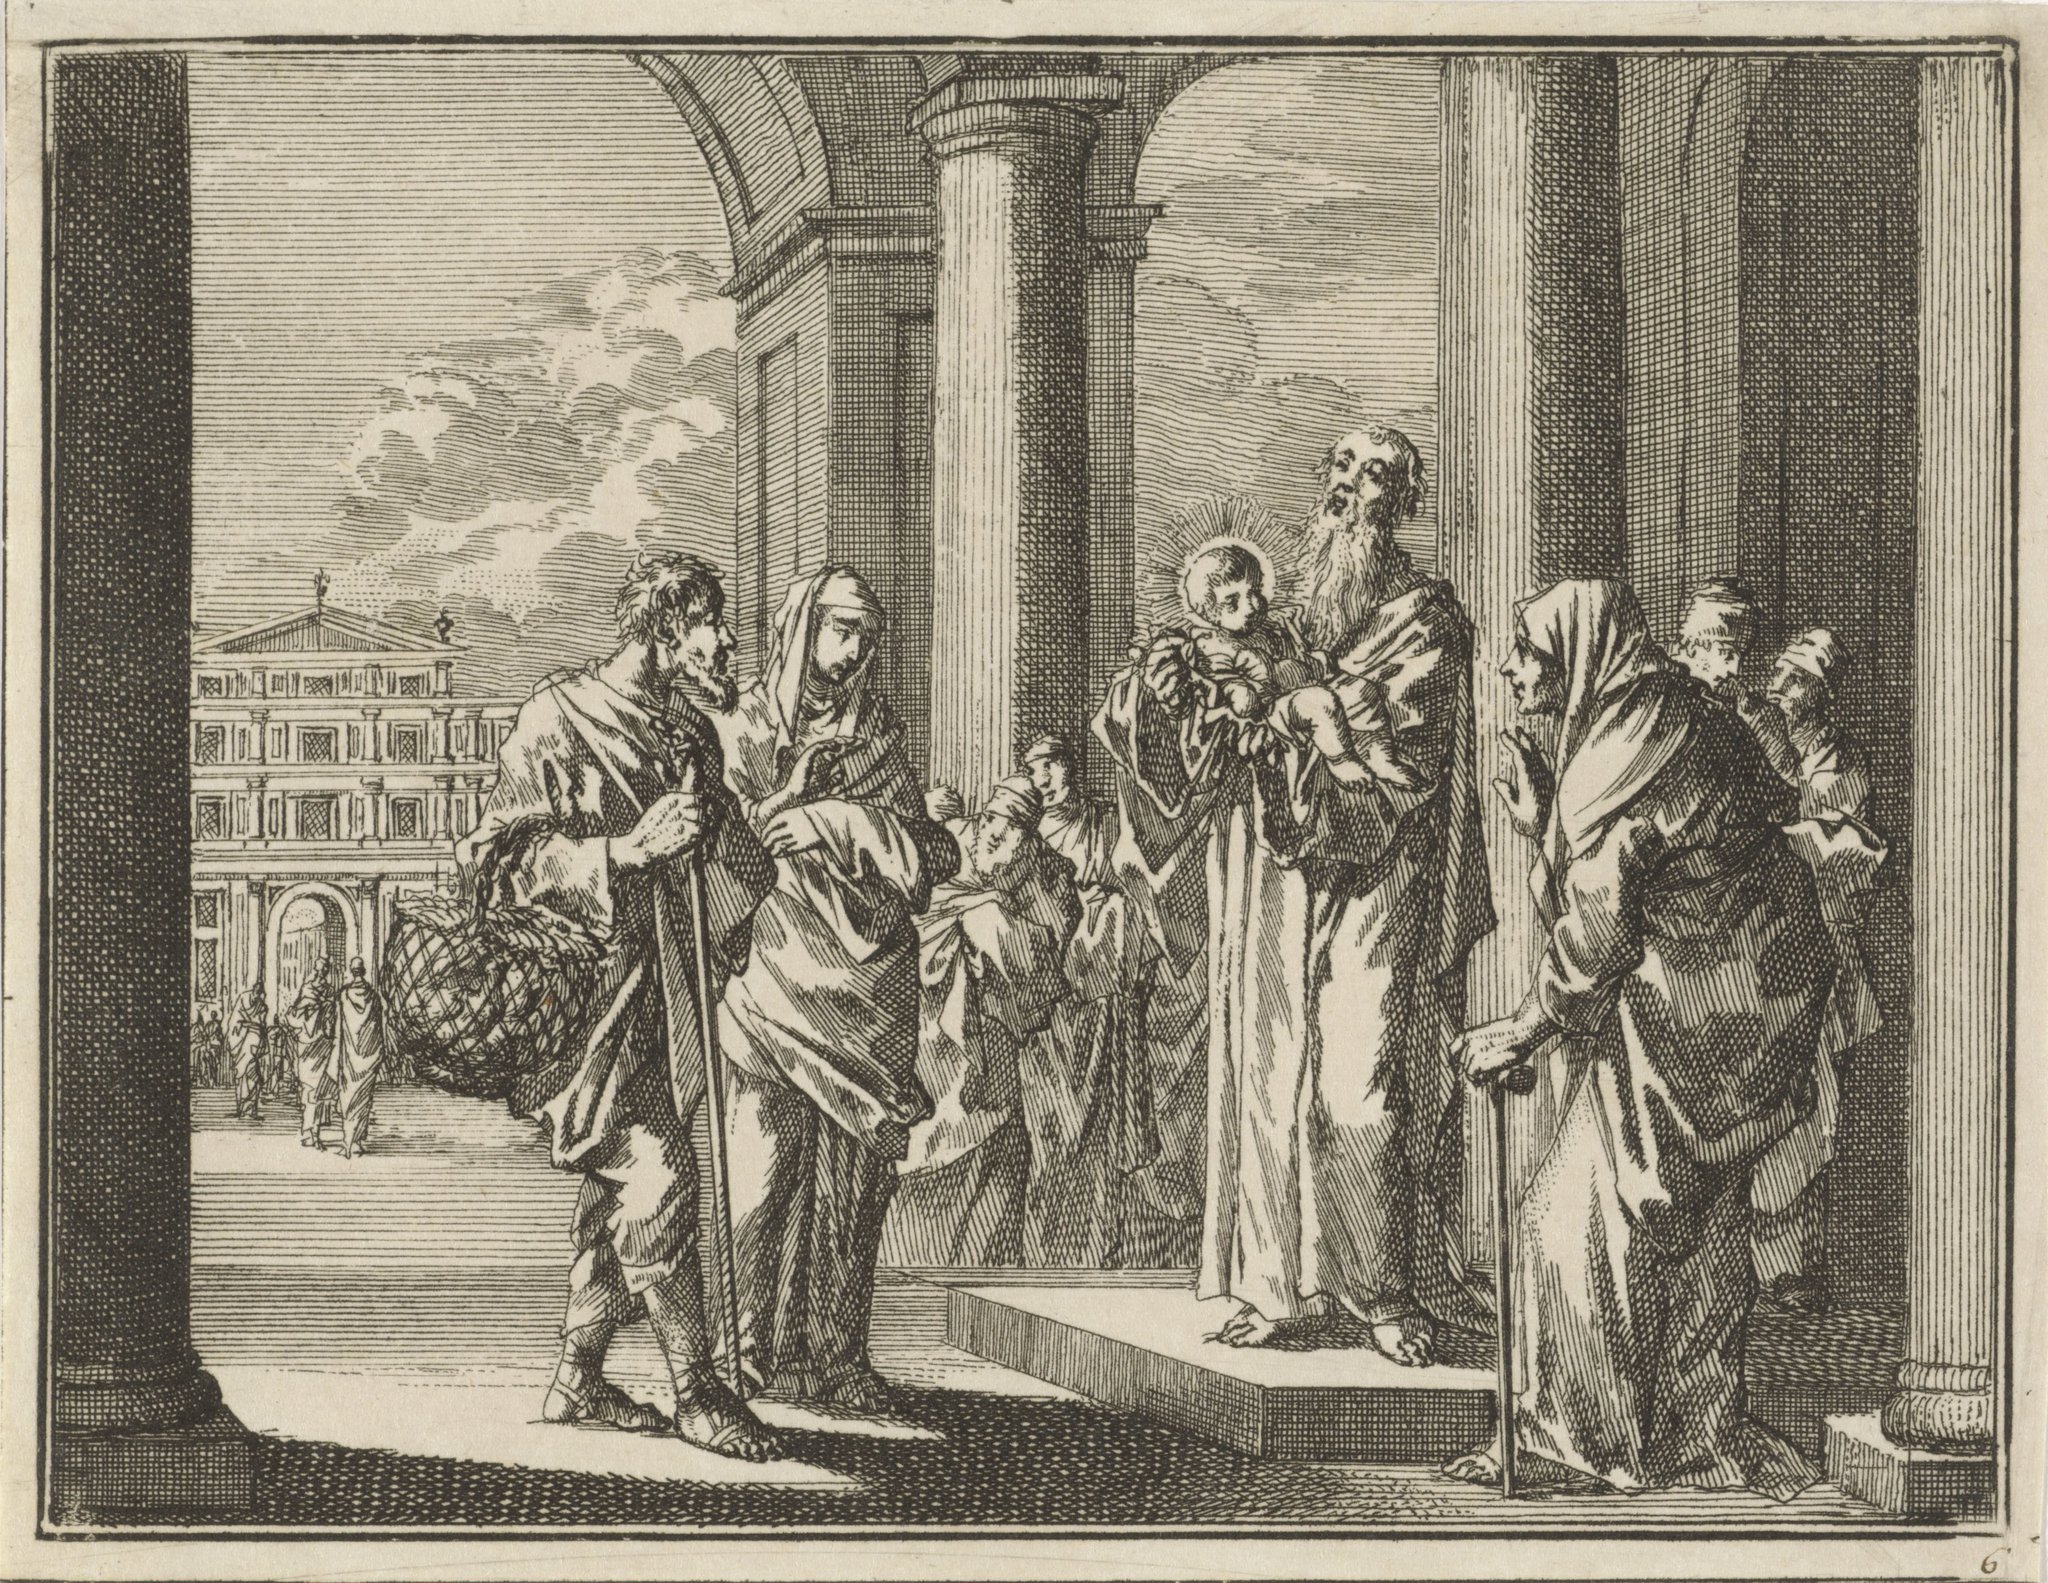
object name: print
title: Presentatie van Christus in de tempel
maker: jan luyken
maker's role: draughtsman, print maker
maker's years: 1649-1712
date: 1712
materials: paper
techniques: etching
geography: amsterdam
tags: simeon, holding the christ-child, sings his canticle: 'nunc dimittis'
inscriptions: number: ‘6’, collector's mark: Lugt 2228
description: Proefdruk van illustratie uit: Luyken, Jan. De schriftuurlyke geschiedenissen en gelykenissen van het Oude en Nieuwe Verbond, 2 delen. Amsterdam: Wed. Pieter Arentsz II en Cornelis van der Sys, 1712, dl. II.